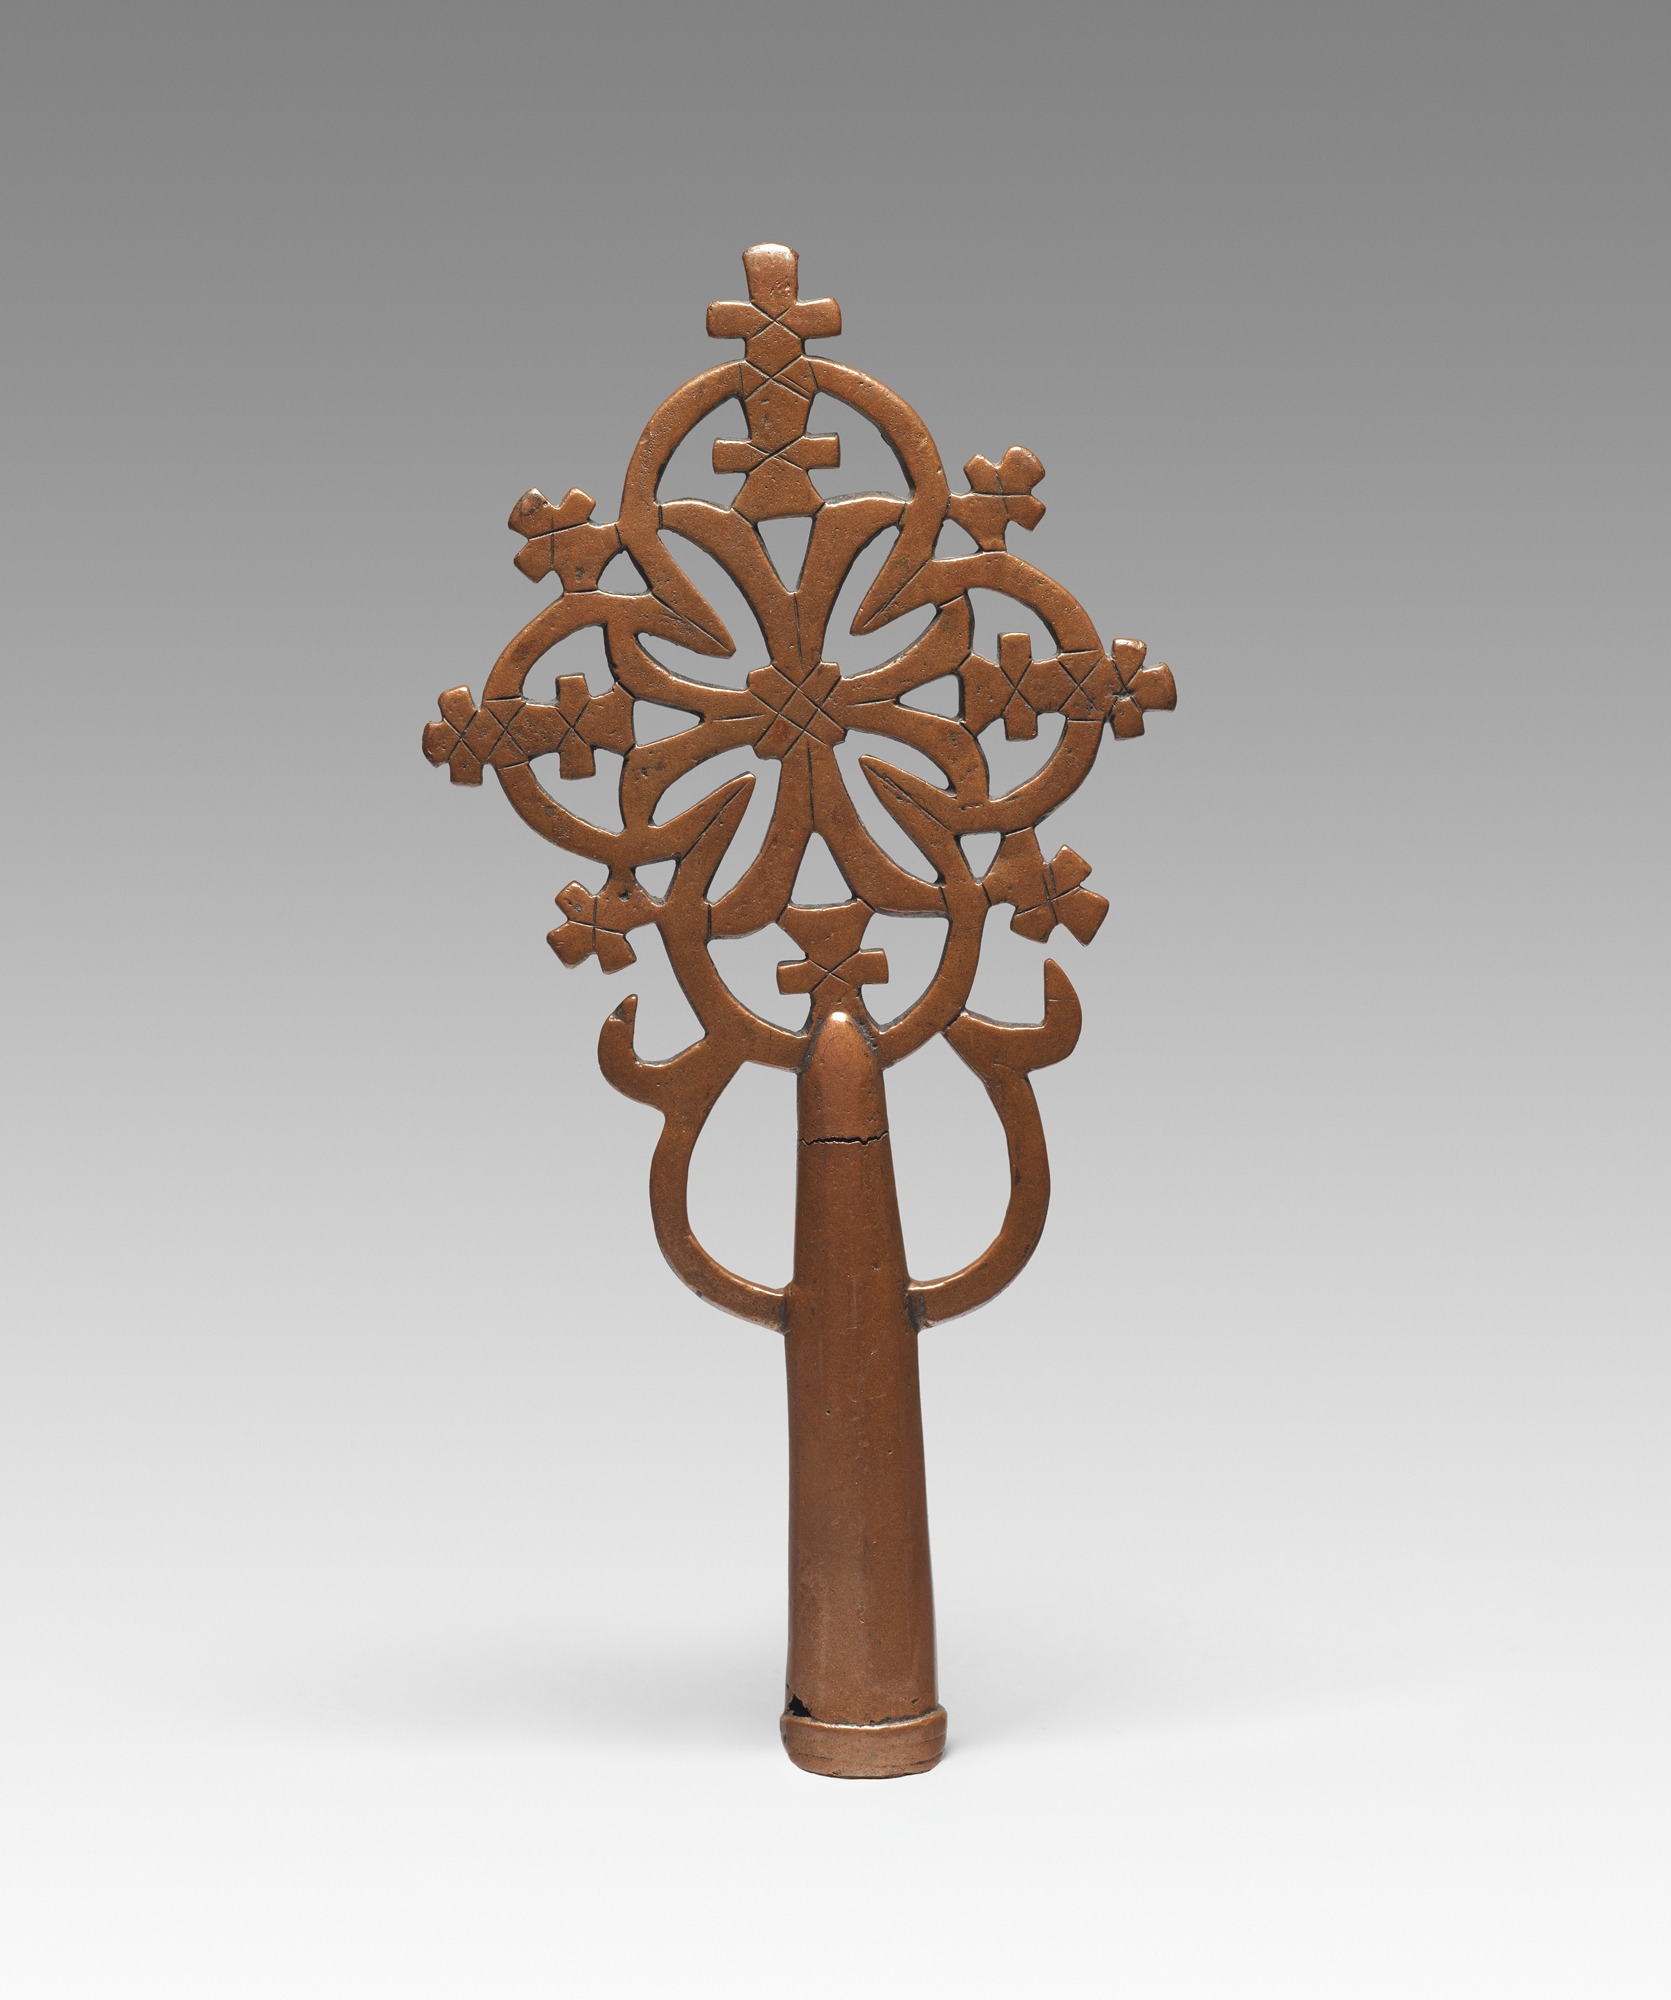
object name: cross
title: Processional Cross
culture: ethiopian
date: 1201-1333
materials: copper alloy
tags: cross